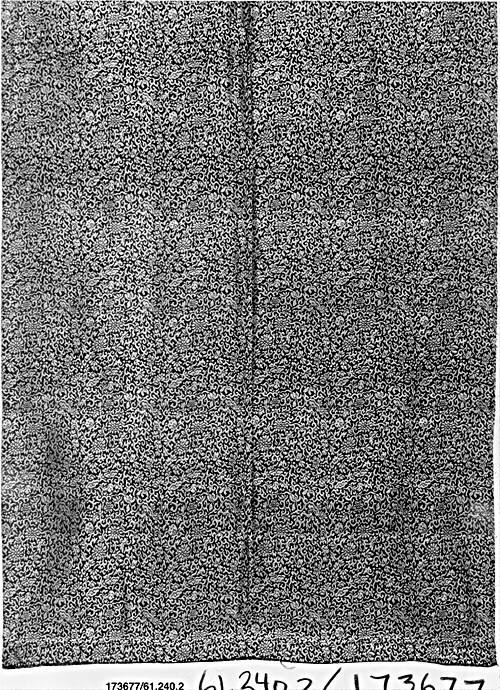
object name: piece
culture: chinese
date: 1601-1800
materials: metal thread, silk